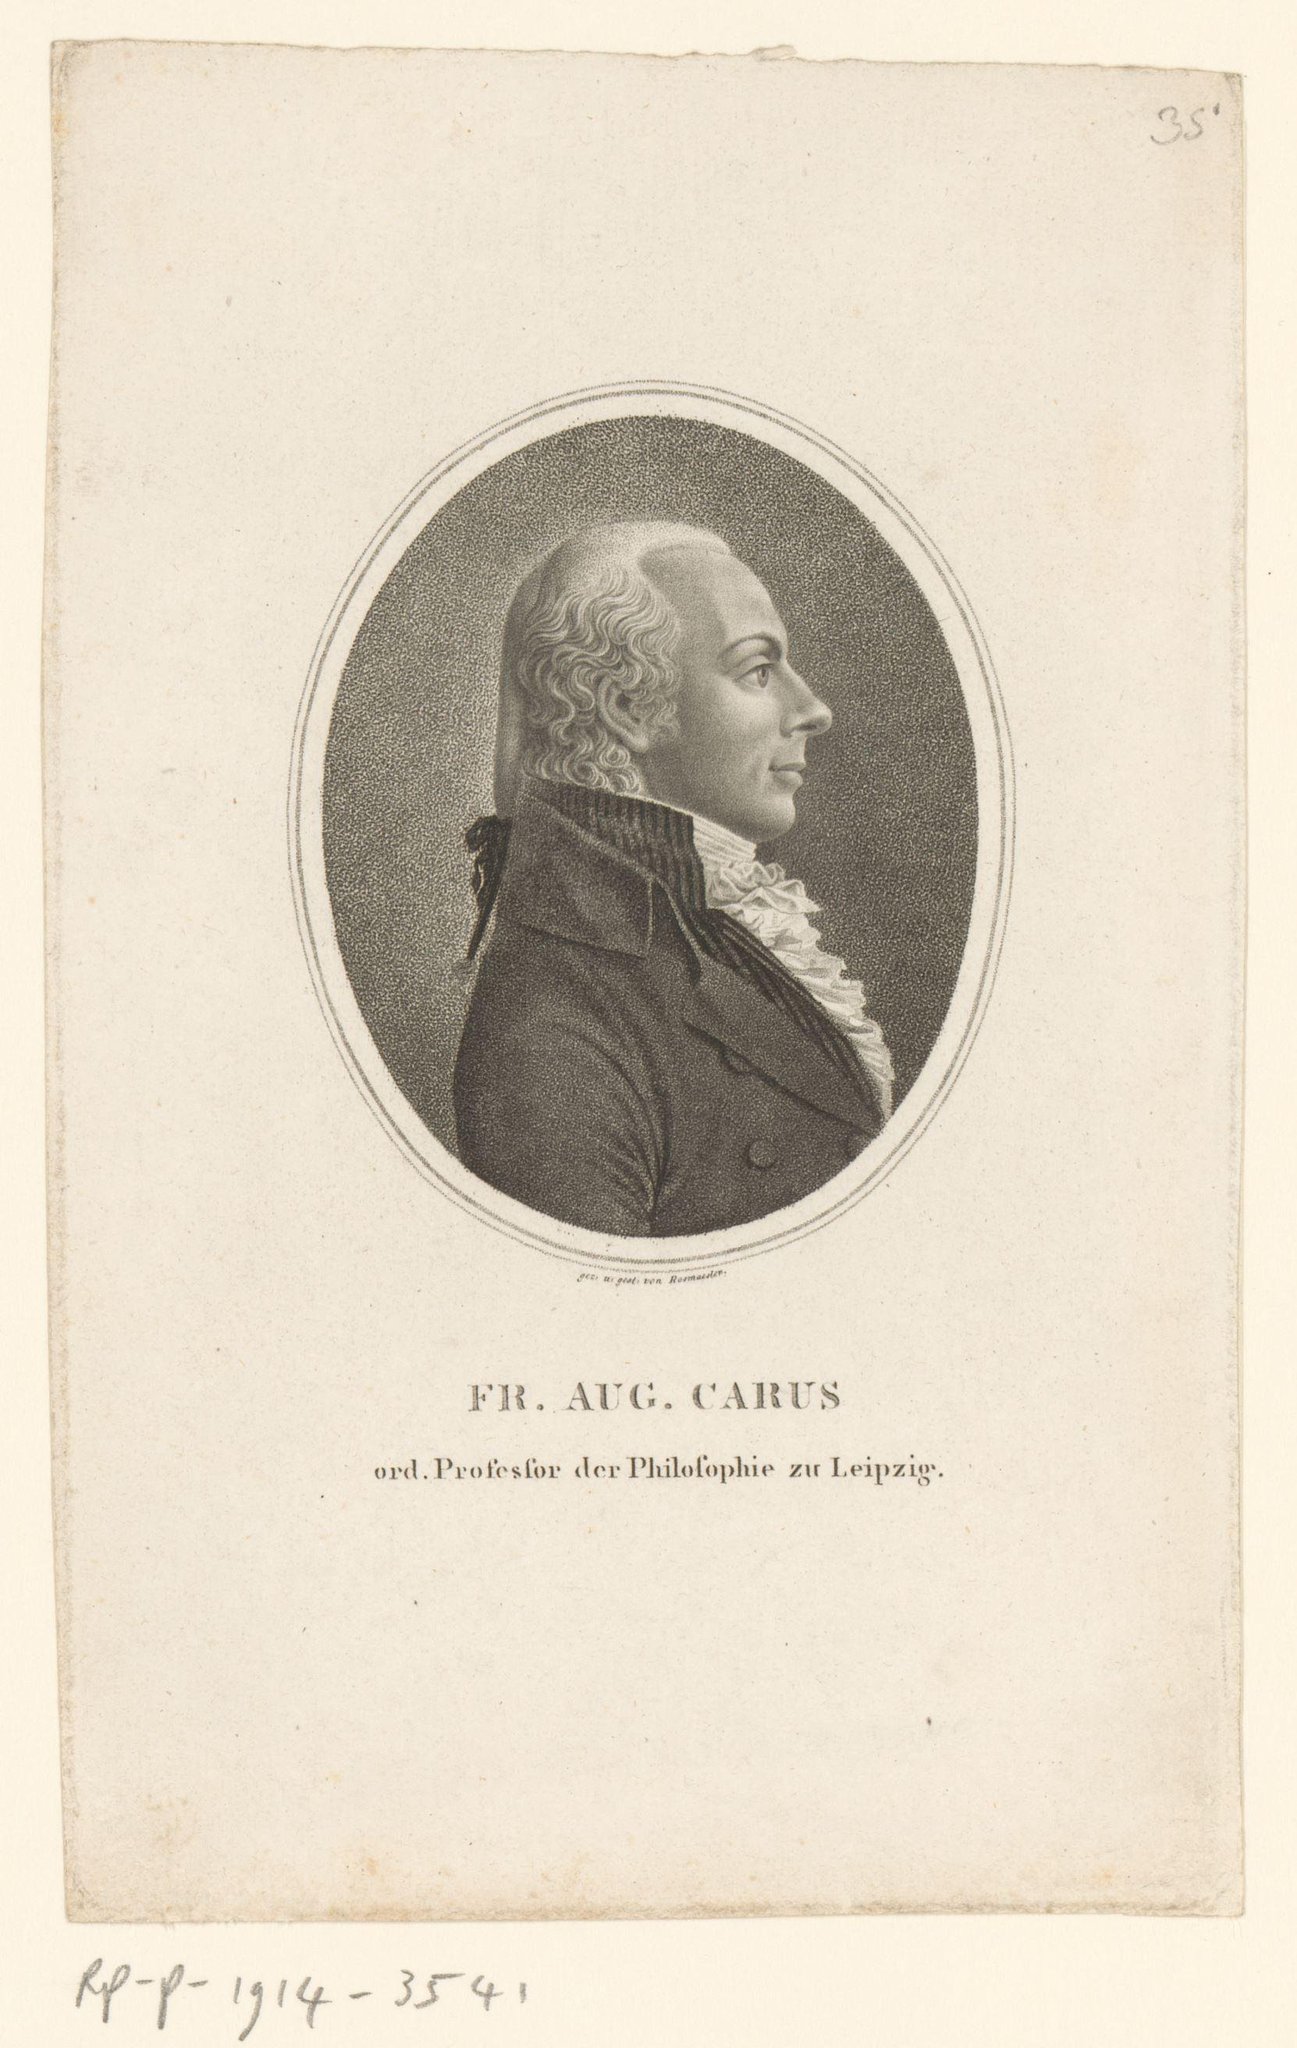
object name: print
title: Portret van Friedrich August Carus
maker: friedrich rossmässler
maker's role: print maker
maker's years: 1775-1858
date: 1785-1858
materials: paper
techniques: engraving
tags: historical persons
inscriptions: collector's mark: Lugt 2228